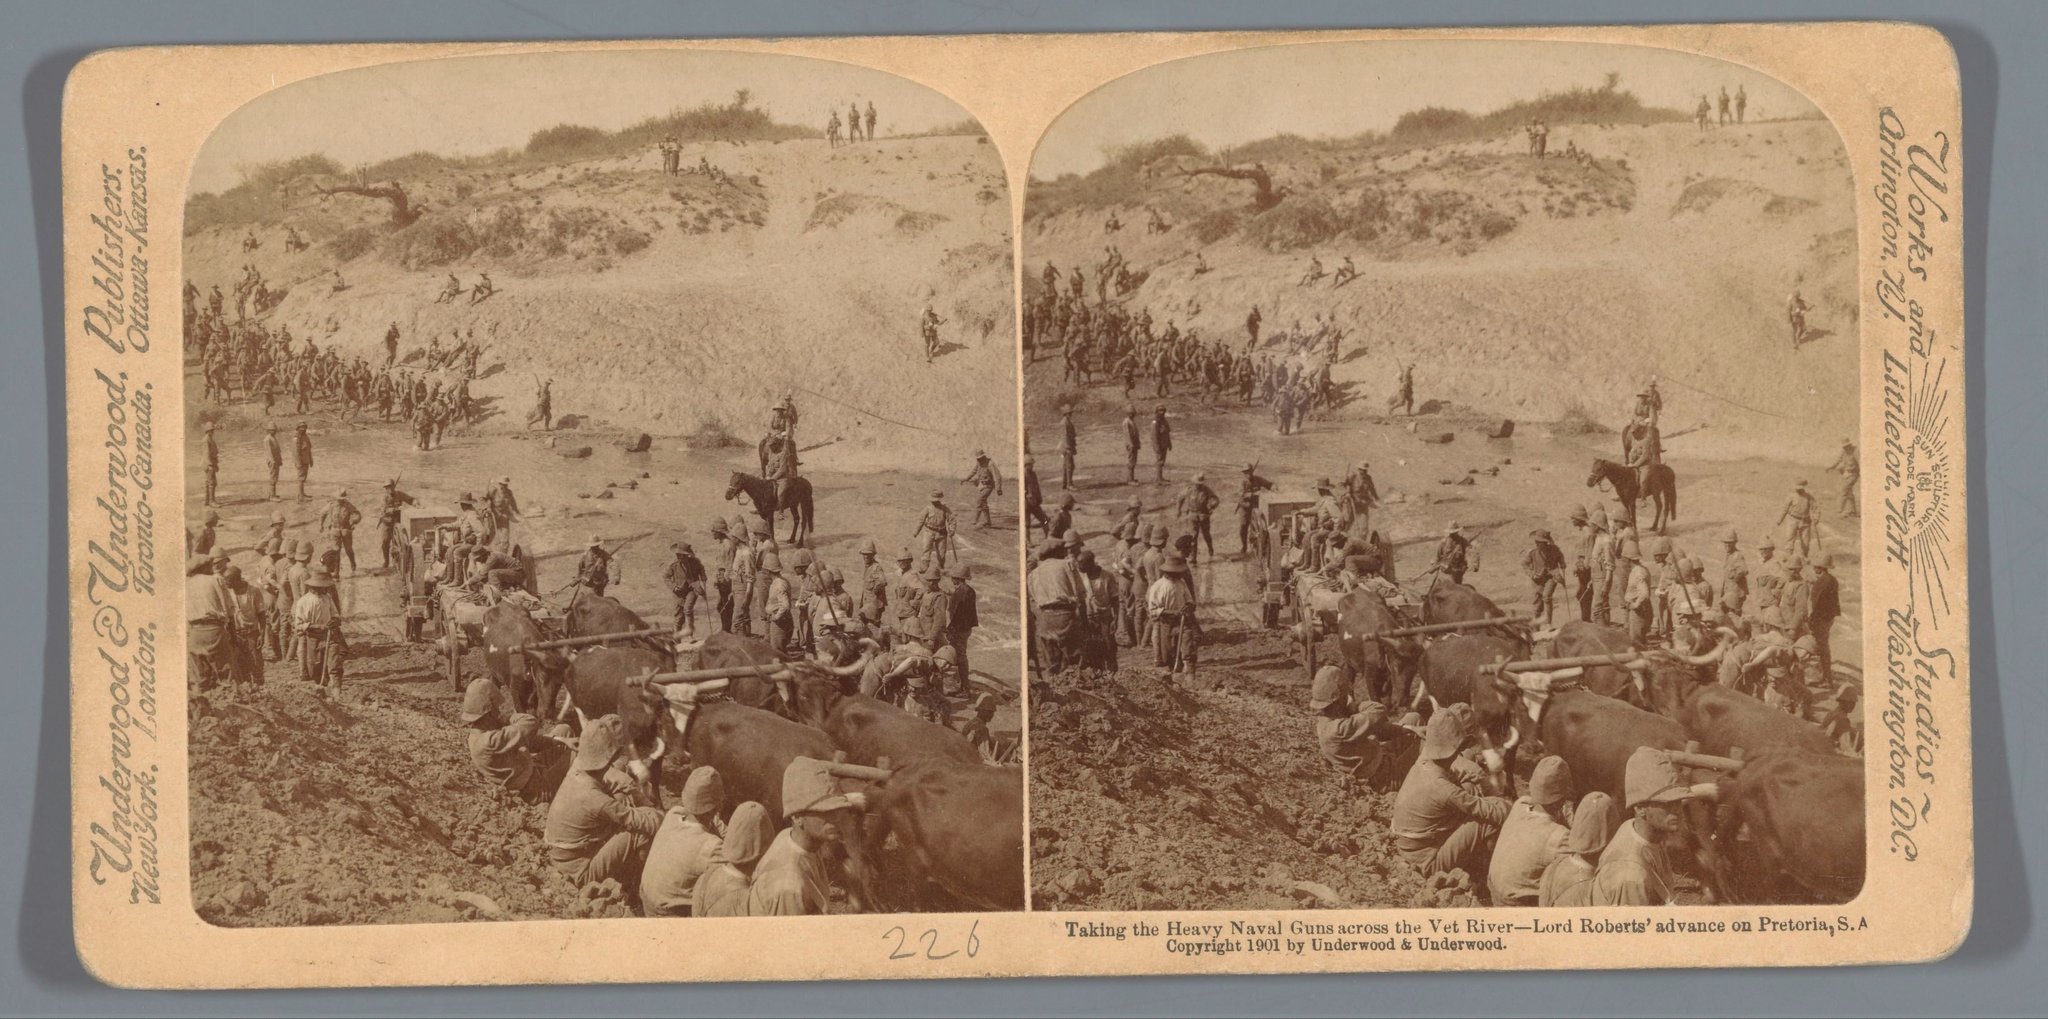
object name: stereograph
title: Geënsceneerde voorstelling van Britse soldaten die de Vetrivier in Zuid-Afrika oversteken met kanonnen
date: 1901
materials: cardboard, photographic support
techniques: albumen print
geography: south africa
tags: troop movements, transportation, firearms: cannon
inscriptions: number: ‘226’, name: ‘Works and Studios Sun Sculpture trade mark Arlington N.J. Littleton N.H. Washington D.C.’